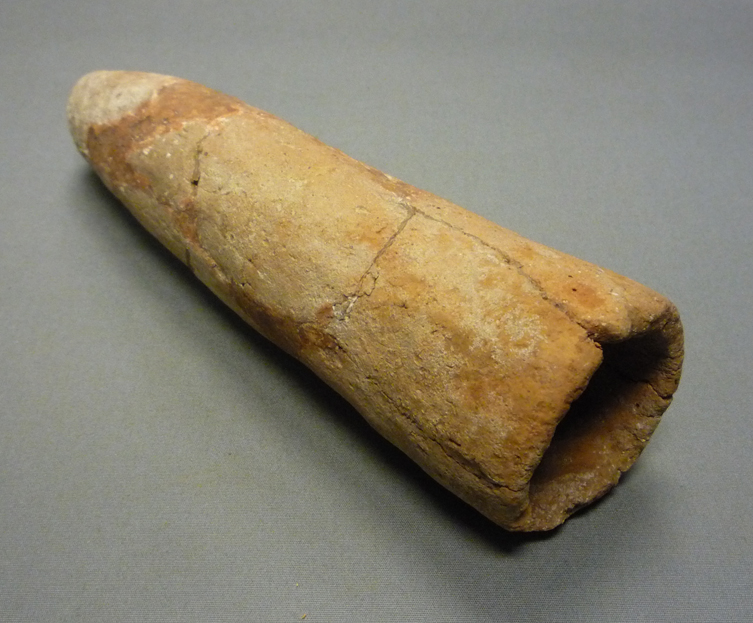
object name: crucible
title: Smelter's Crucible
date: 1479-1458 BCE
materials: pottery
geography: egypt